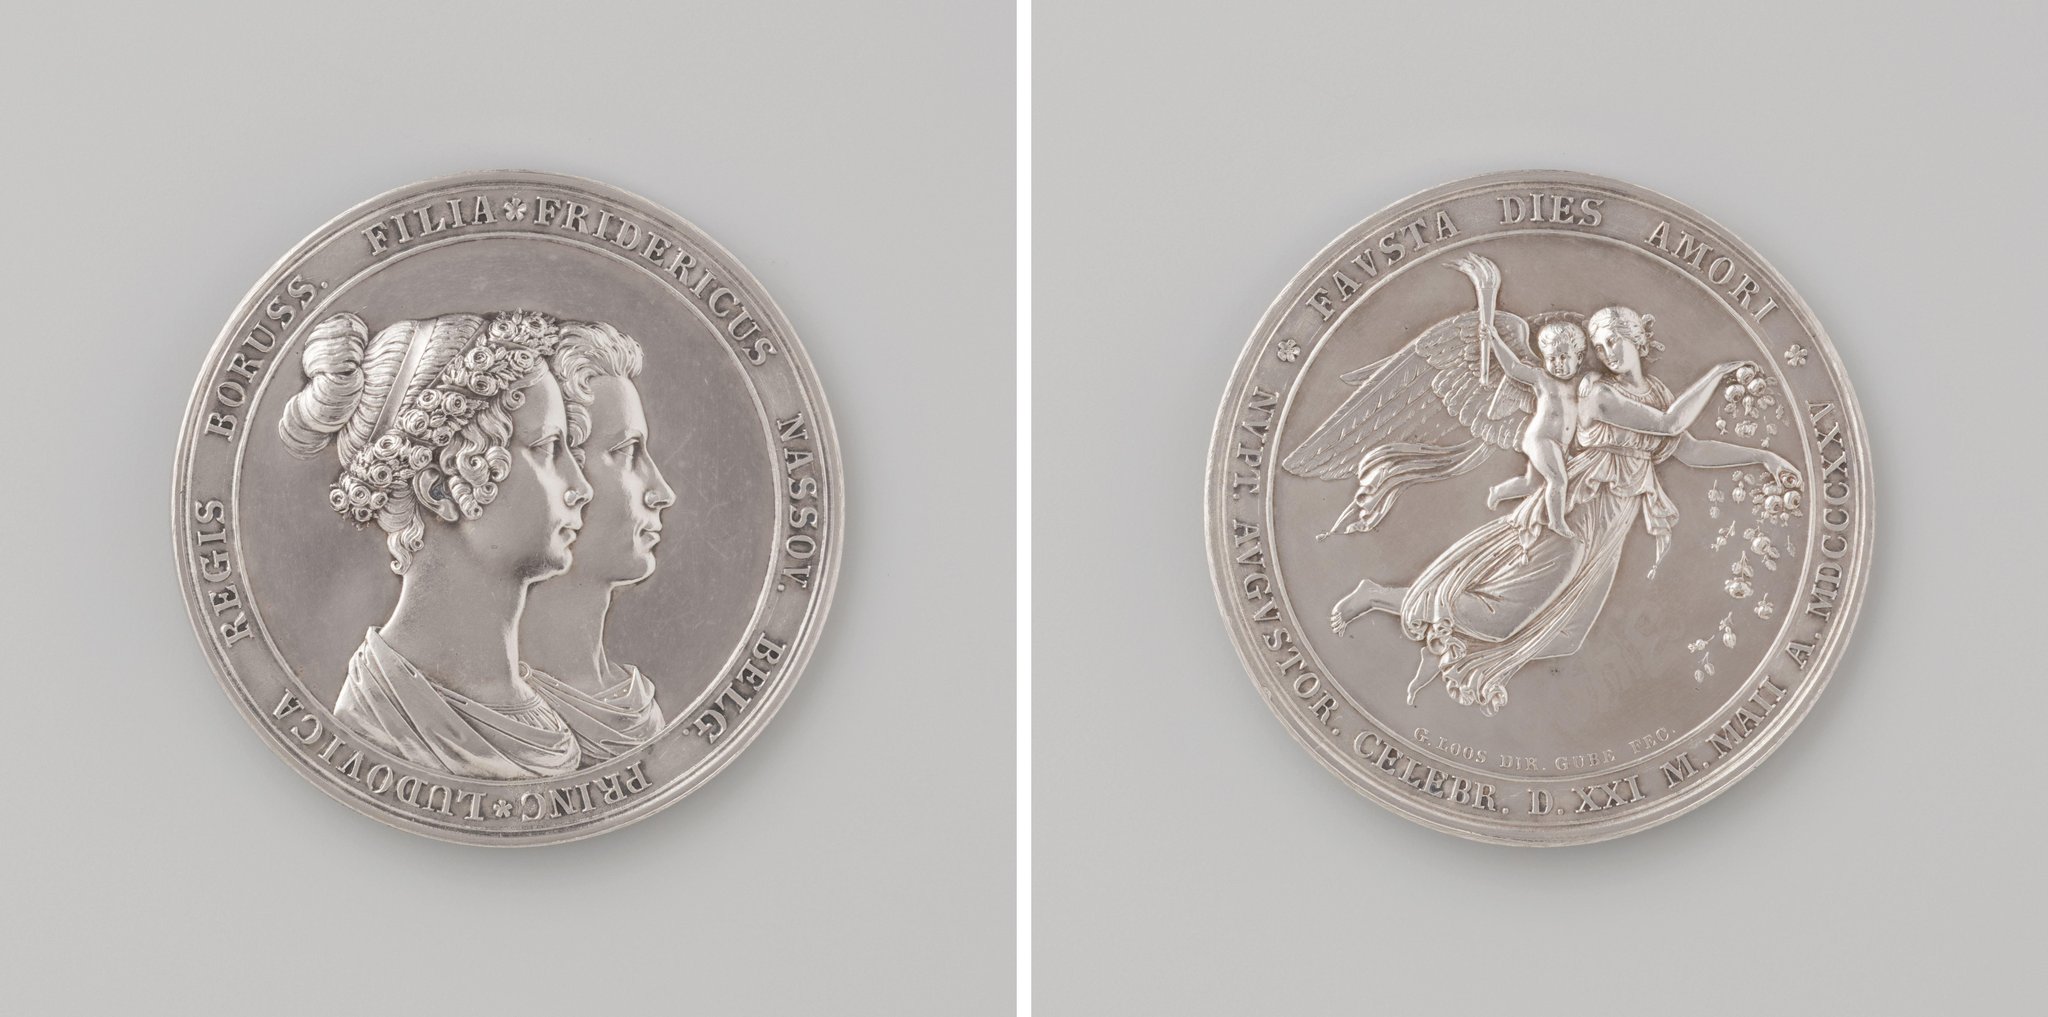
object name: history medal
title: Huwelijk van Frederik, prins der Nederlanden en Louise, prinses van Pruisen te Berlijn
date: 1825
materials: silver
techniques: striking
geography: berlin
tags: berlin, frederik (prins der nederlanden)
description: Zilveren penning. Voorzijde: borststuk vrouw en man binnen omschrift. Keerzijde: zwevende Venus, strooit rozen terwijl Amor met brandende fakkel, zich aan haar schouder vastklampt binnen omschrift